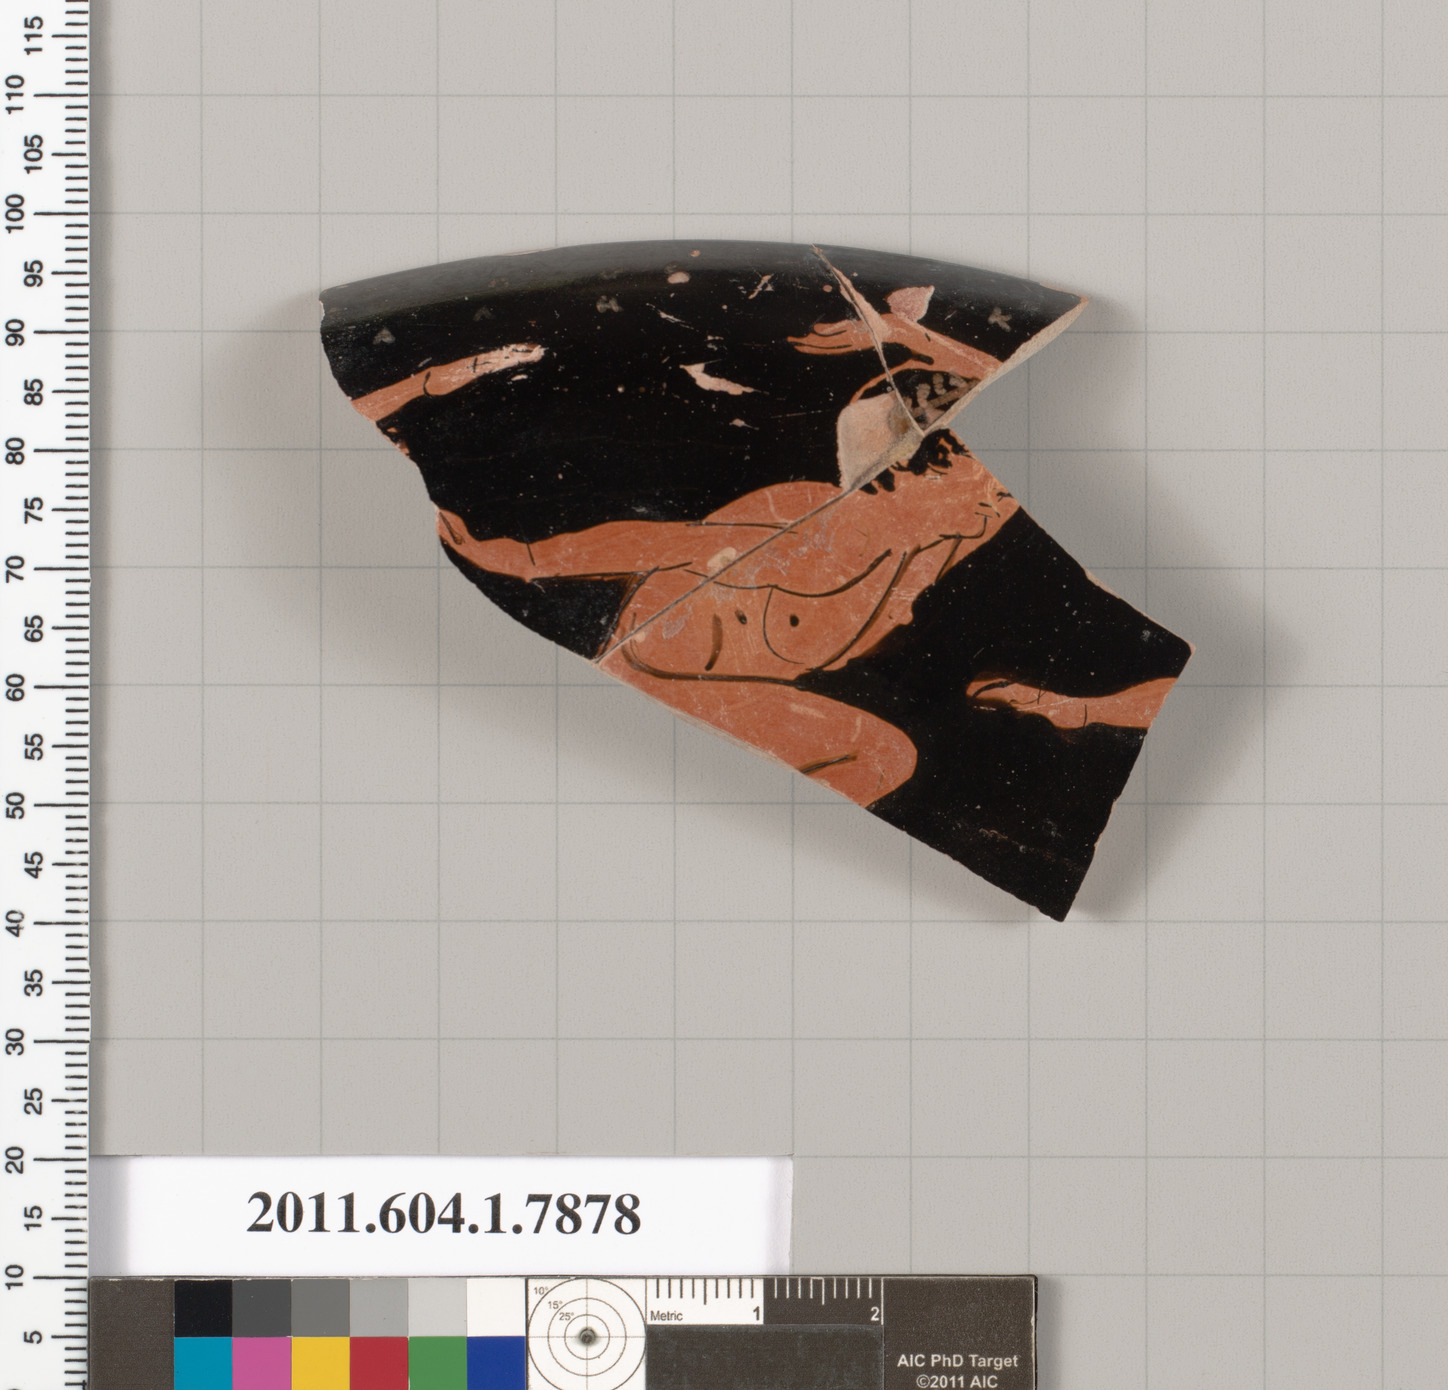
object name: kylix fragment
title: Terracotta rim fragment of a kylix (drinking cup)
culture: greek, attic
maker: veii painter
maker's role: artist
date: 460-450 BCE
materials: terracotta